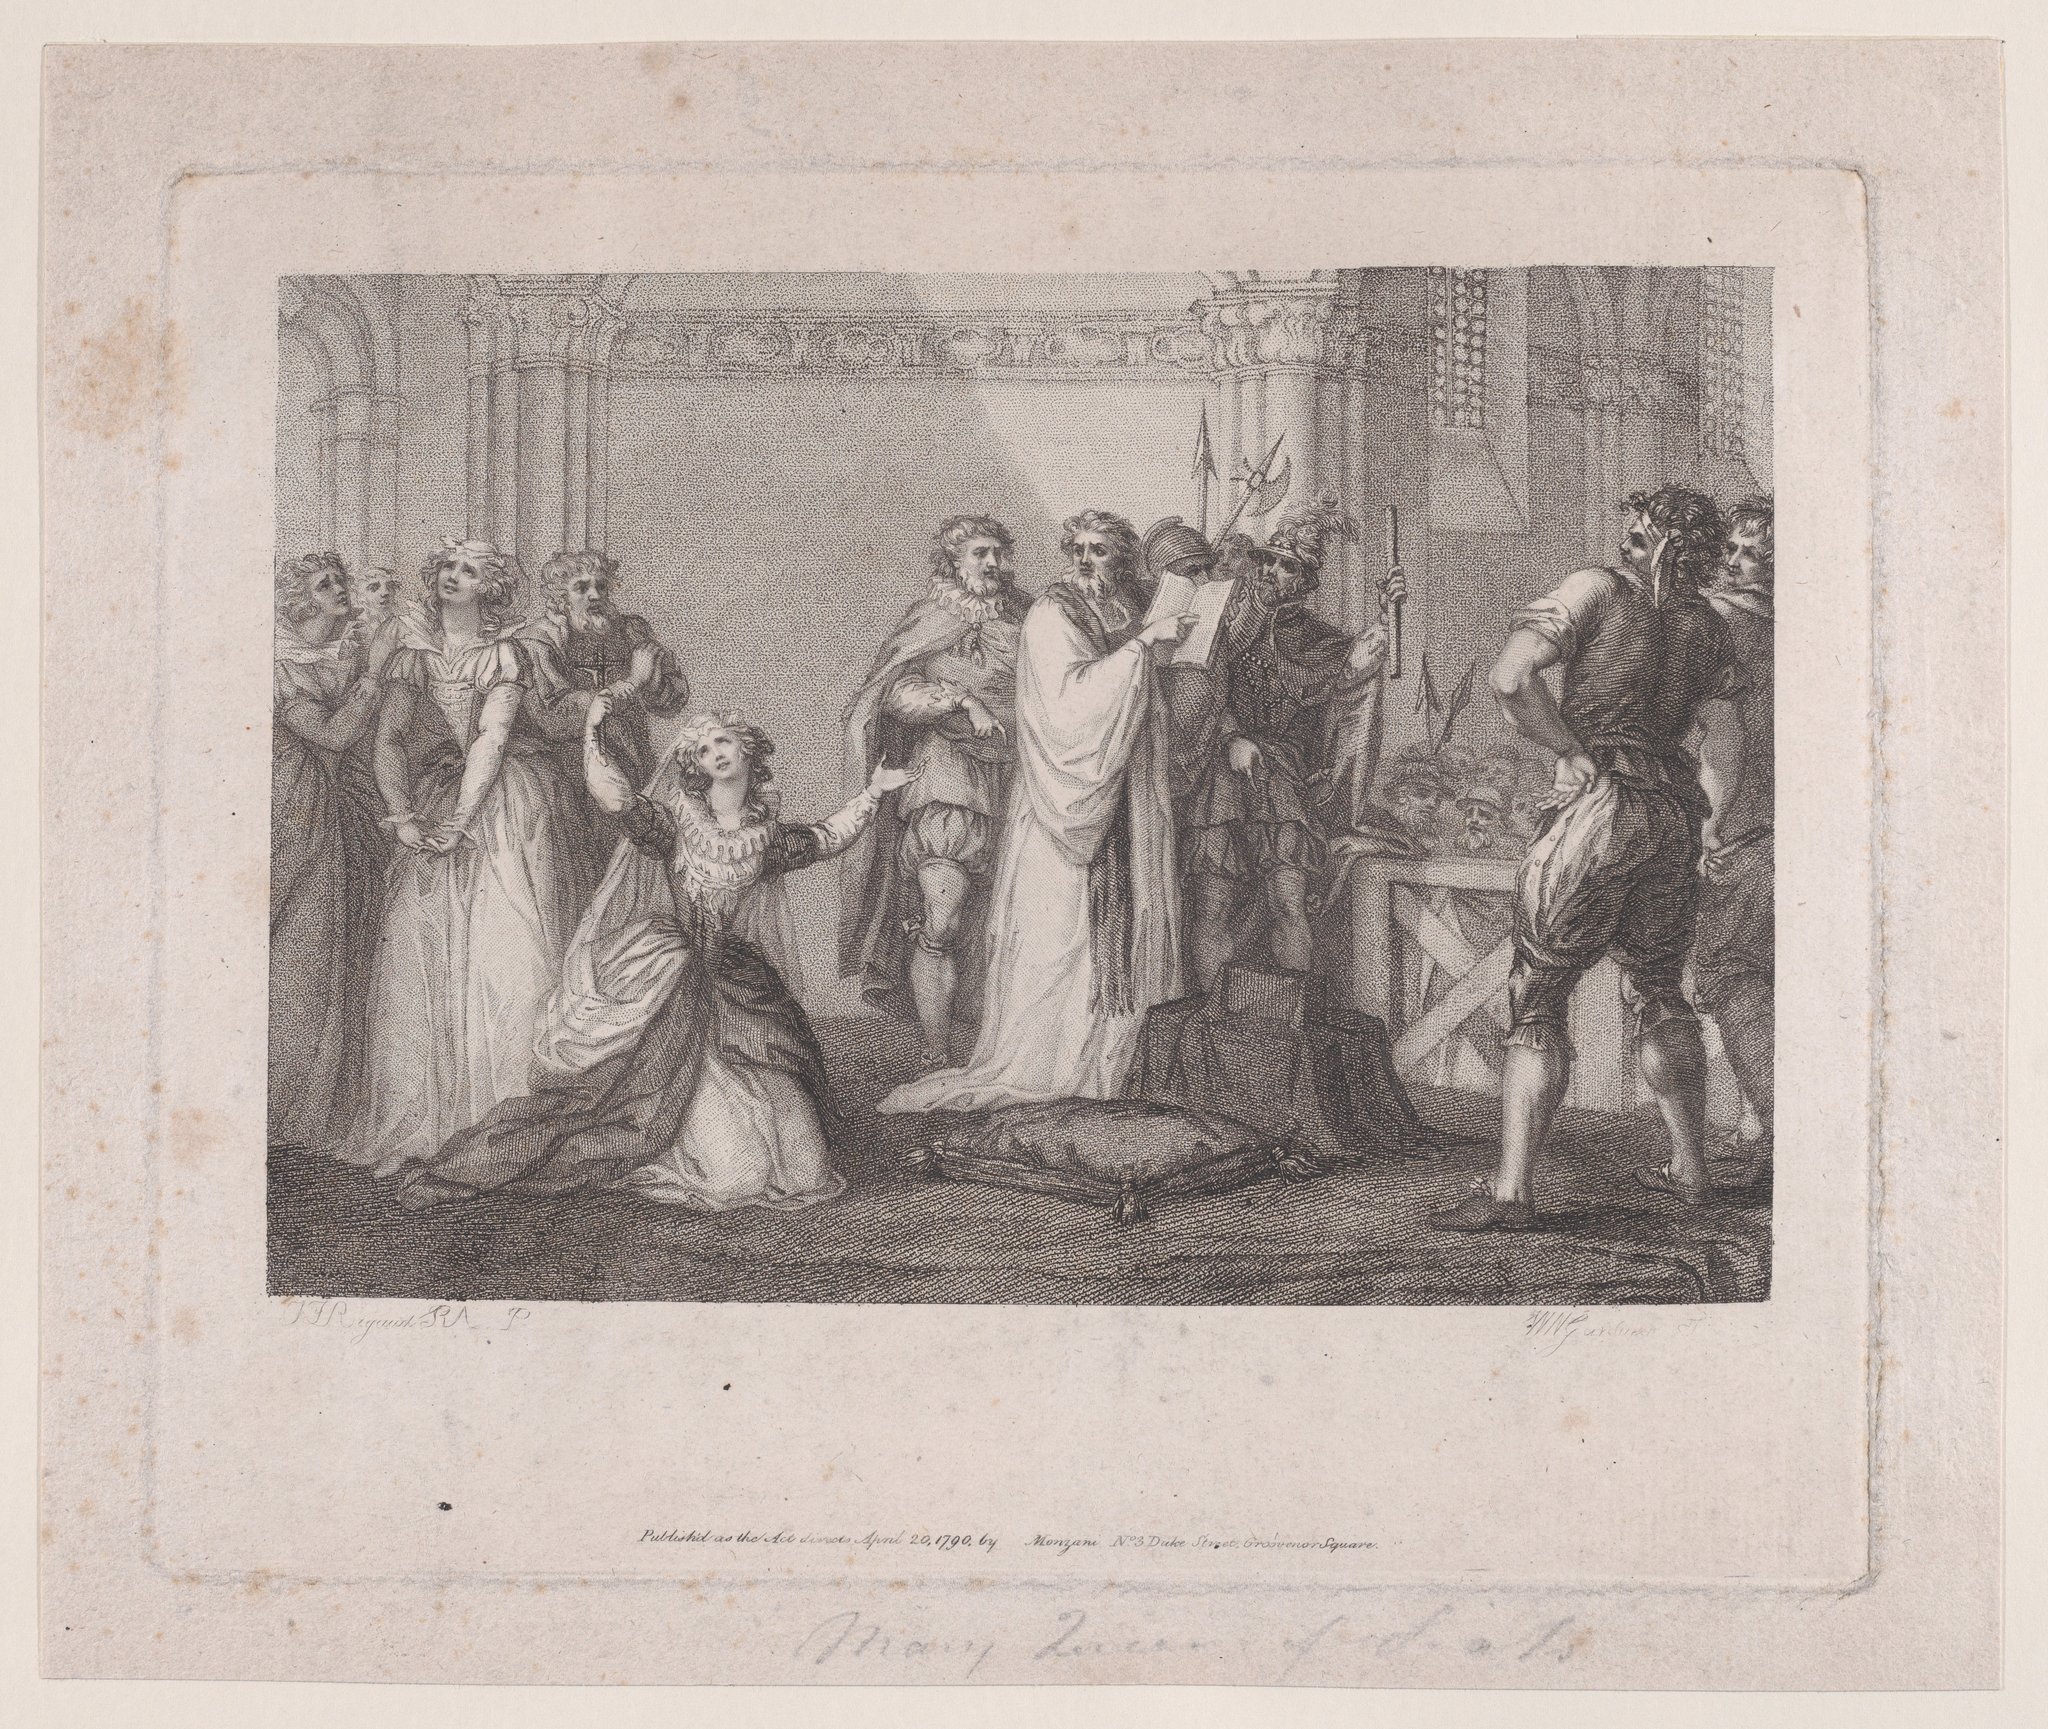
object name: print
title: Mary, Queen of Scots kneeling on the scaffold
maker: william nelson gardiner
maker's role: artist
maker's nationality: british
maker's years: 1766-1814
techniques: engraving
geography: england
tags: queens,men,women,execution,mary queen of scots